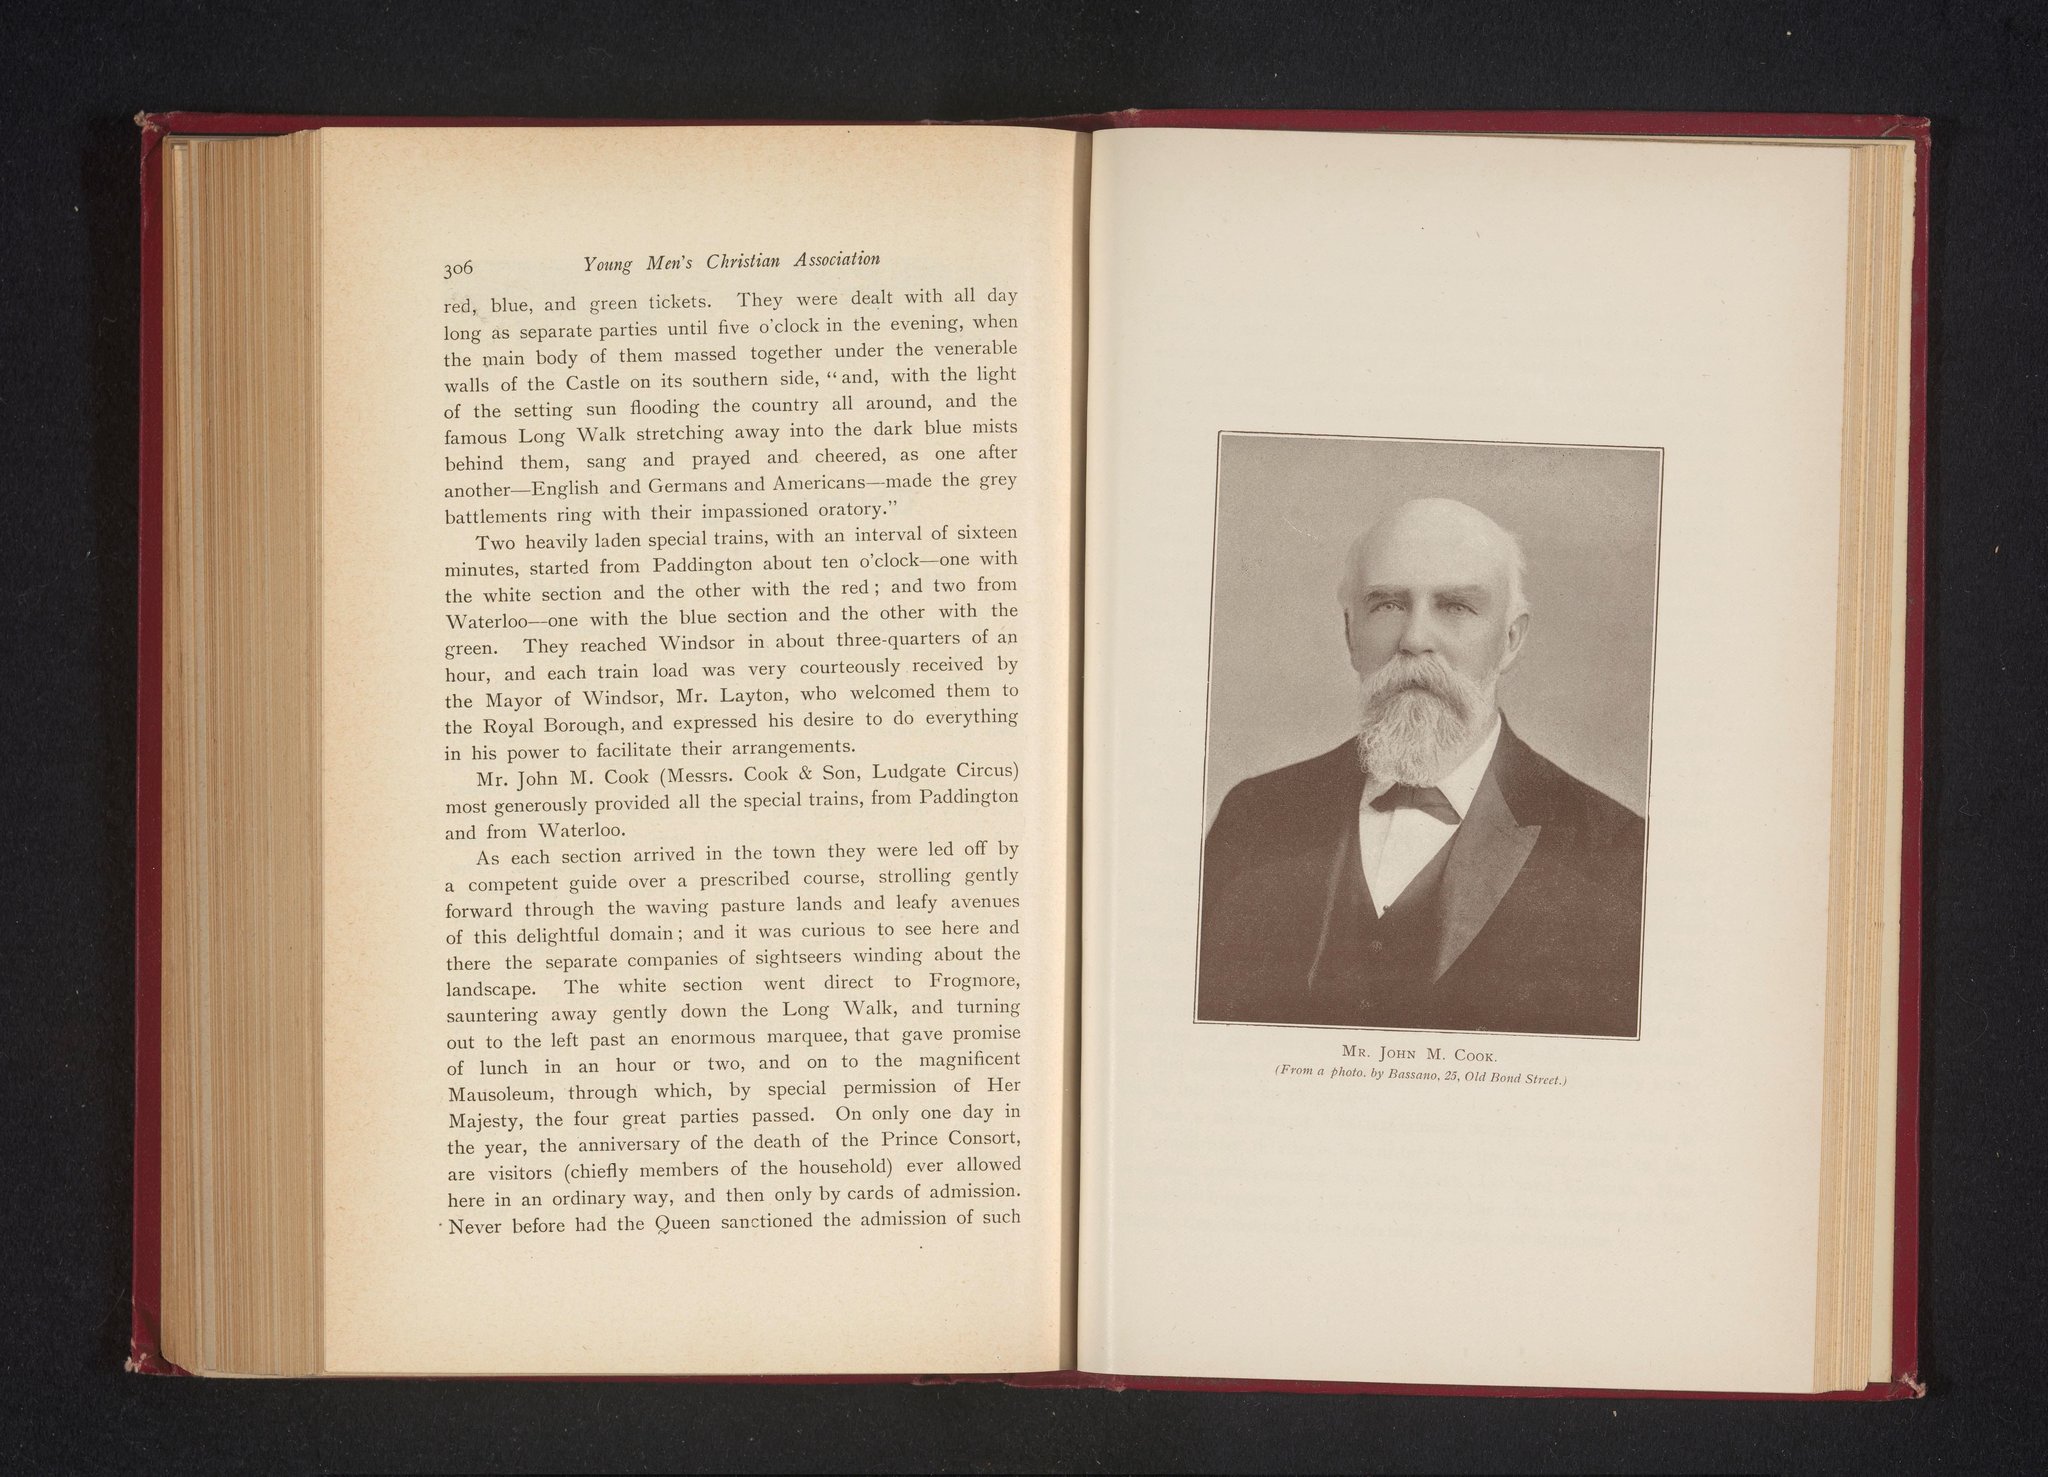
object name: photomechanical print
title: Portret van John M. Cook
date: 1890-1895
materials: paper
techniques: autotype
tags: historical persons